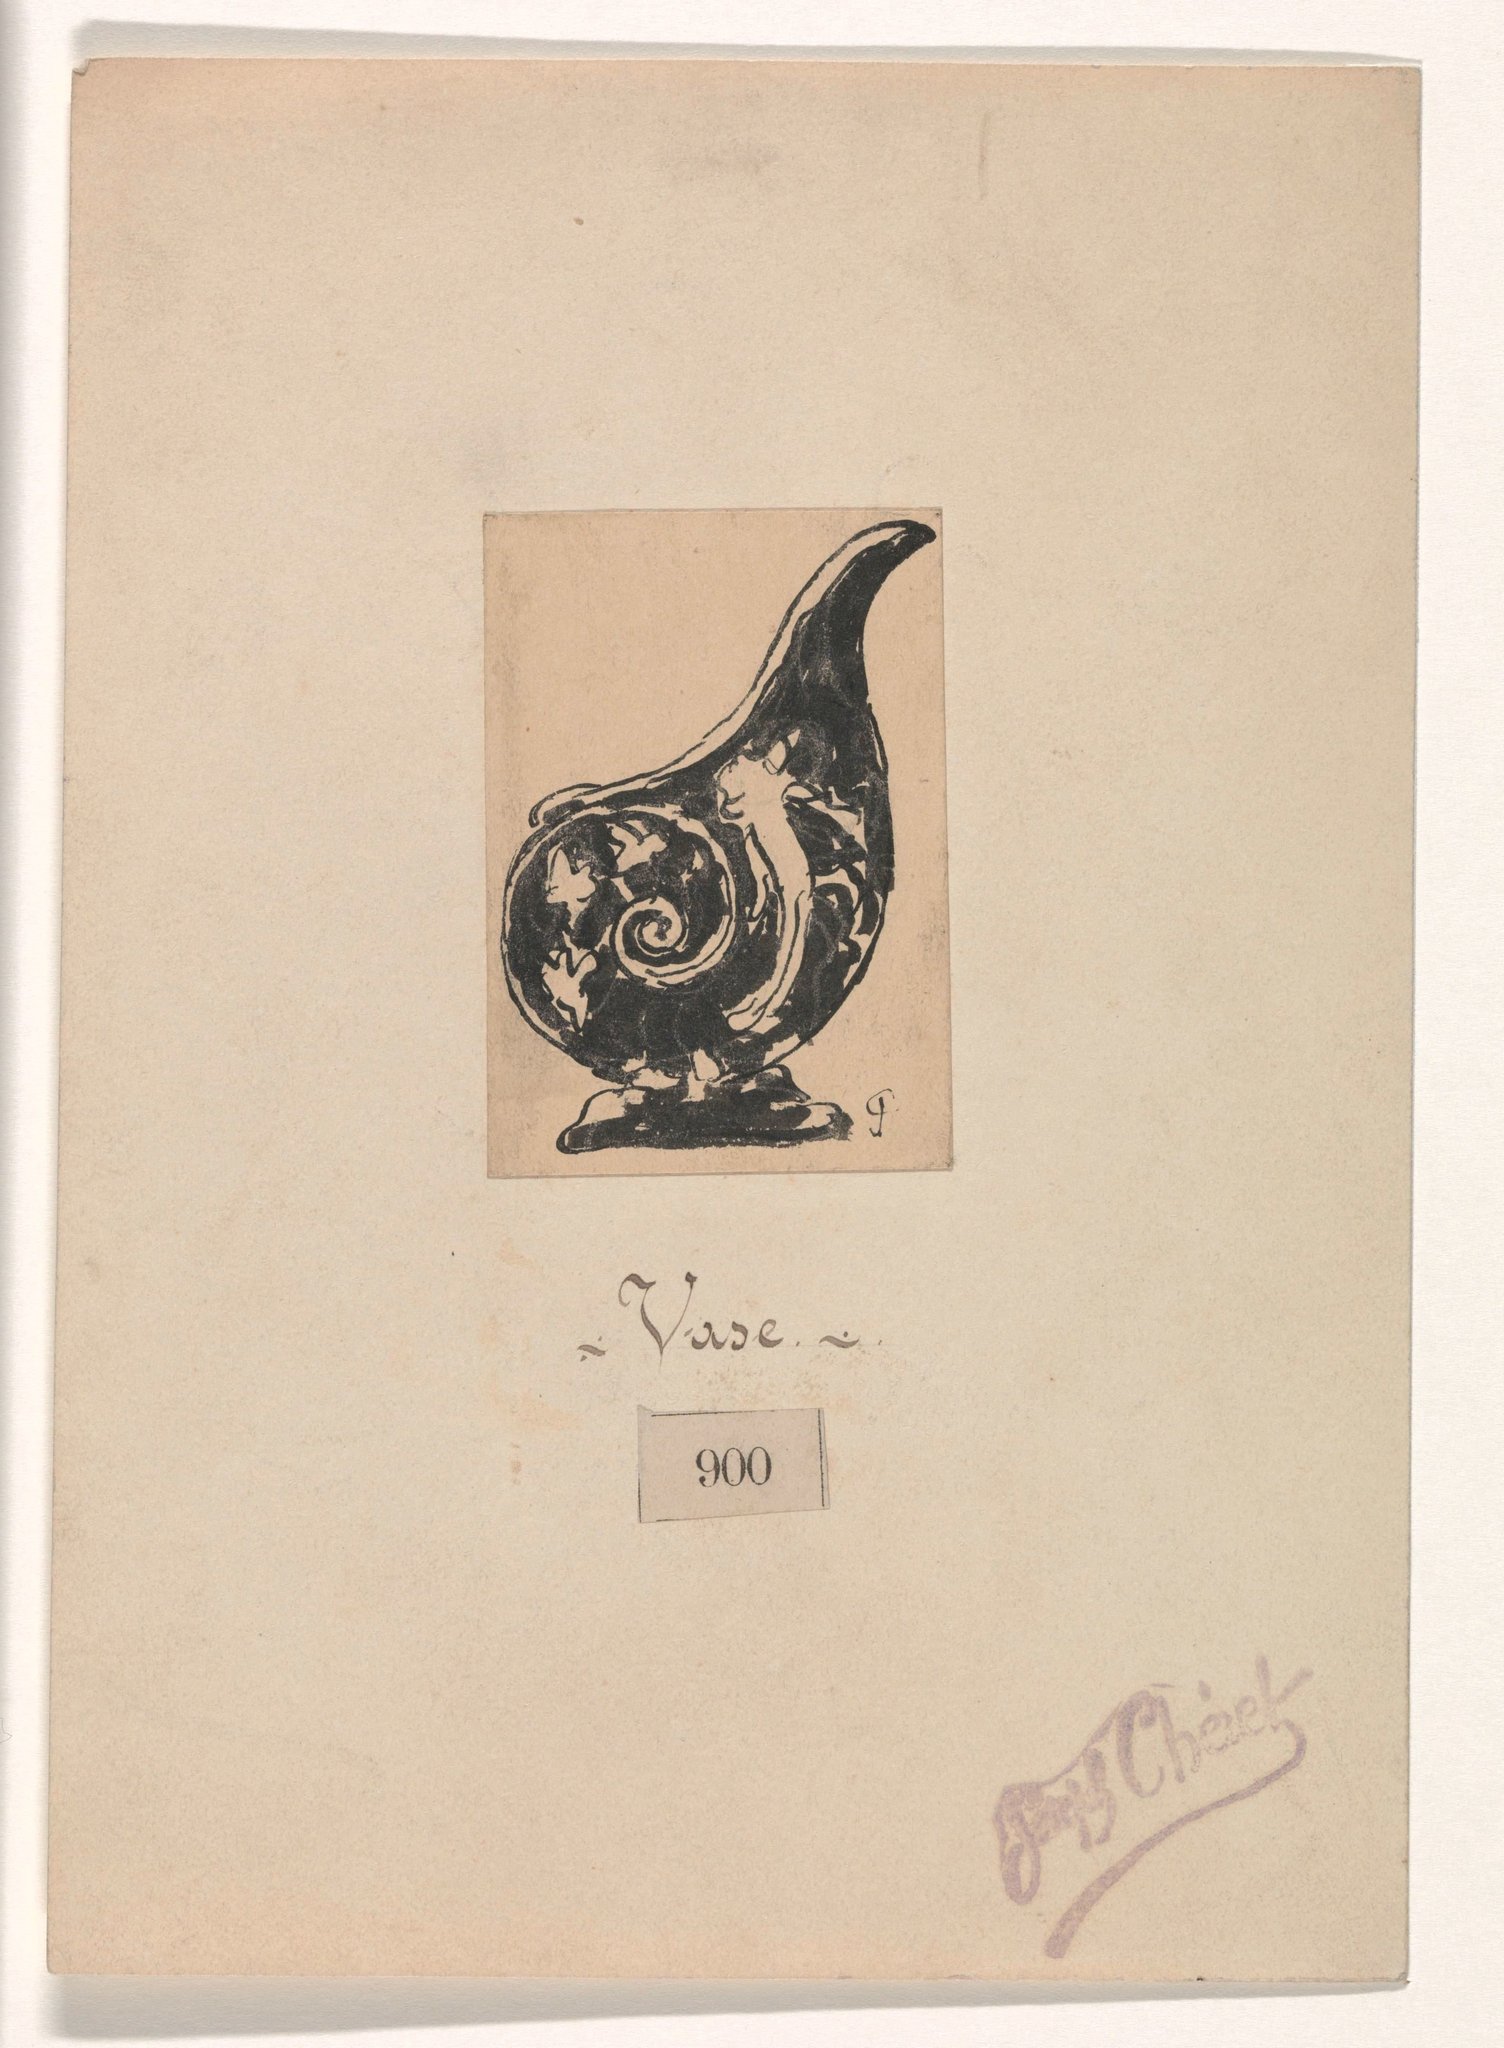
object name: design drawing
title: Schelpvormige kan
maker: gustave joseph chéret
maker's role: sculptor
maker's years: 1838-1894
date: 1870-1894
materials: cardboard, paper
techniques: brush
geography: paris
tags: containers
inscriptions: inscription: ‘Vase’, monogram: ‘JC’, label: ‘900’, workshop stamp: ‘Joseph Chéret’